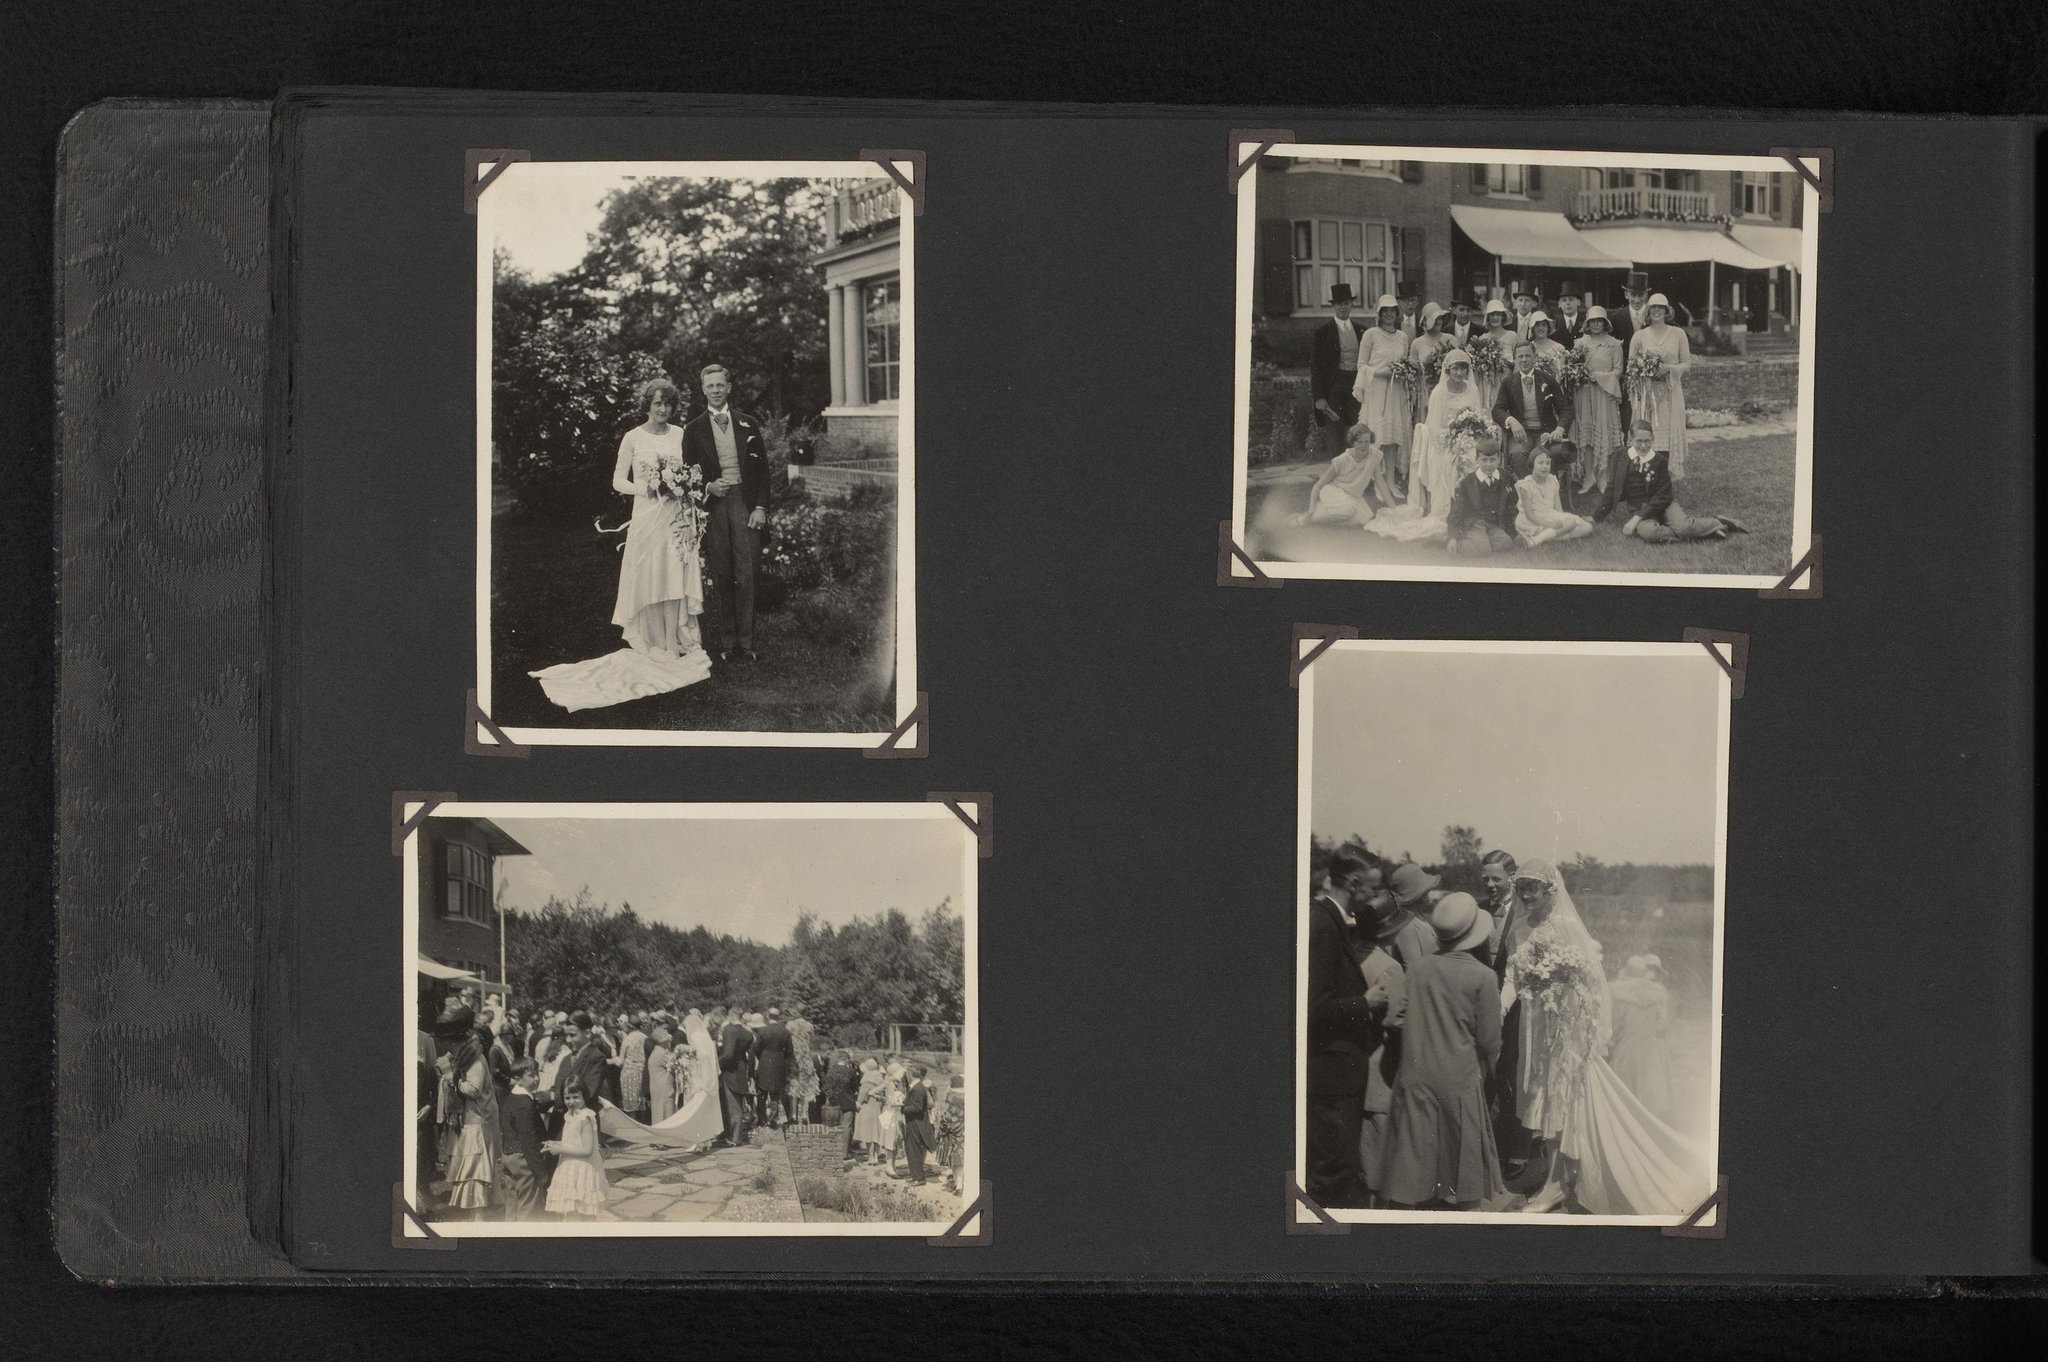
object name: photograph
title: Vier foto's van het huwelijksfeest van Henricus Petrus Joannes van Ketwich Verschuur en Elize de Beaufort bij landhuis De Hooght, Maarn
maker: hendrik herman van den berg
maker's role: amateurfotograaf, jurist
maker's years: 1875-1944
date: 1929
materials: paper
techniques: gelatin silver print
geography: maarn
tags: the hague, wedding feast, wedding meal, garden, bride and groom in wedding-dress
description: Deze foto's maken deel uit van een album.